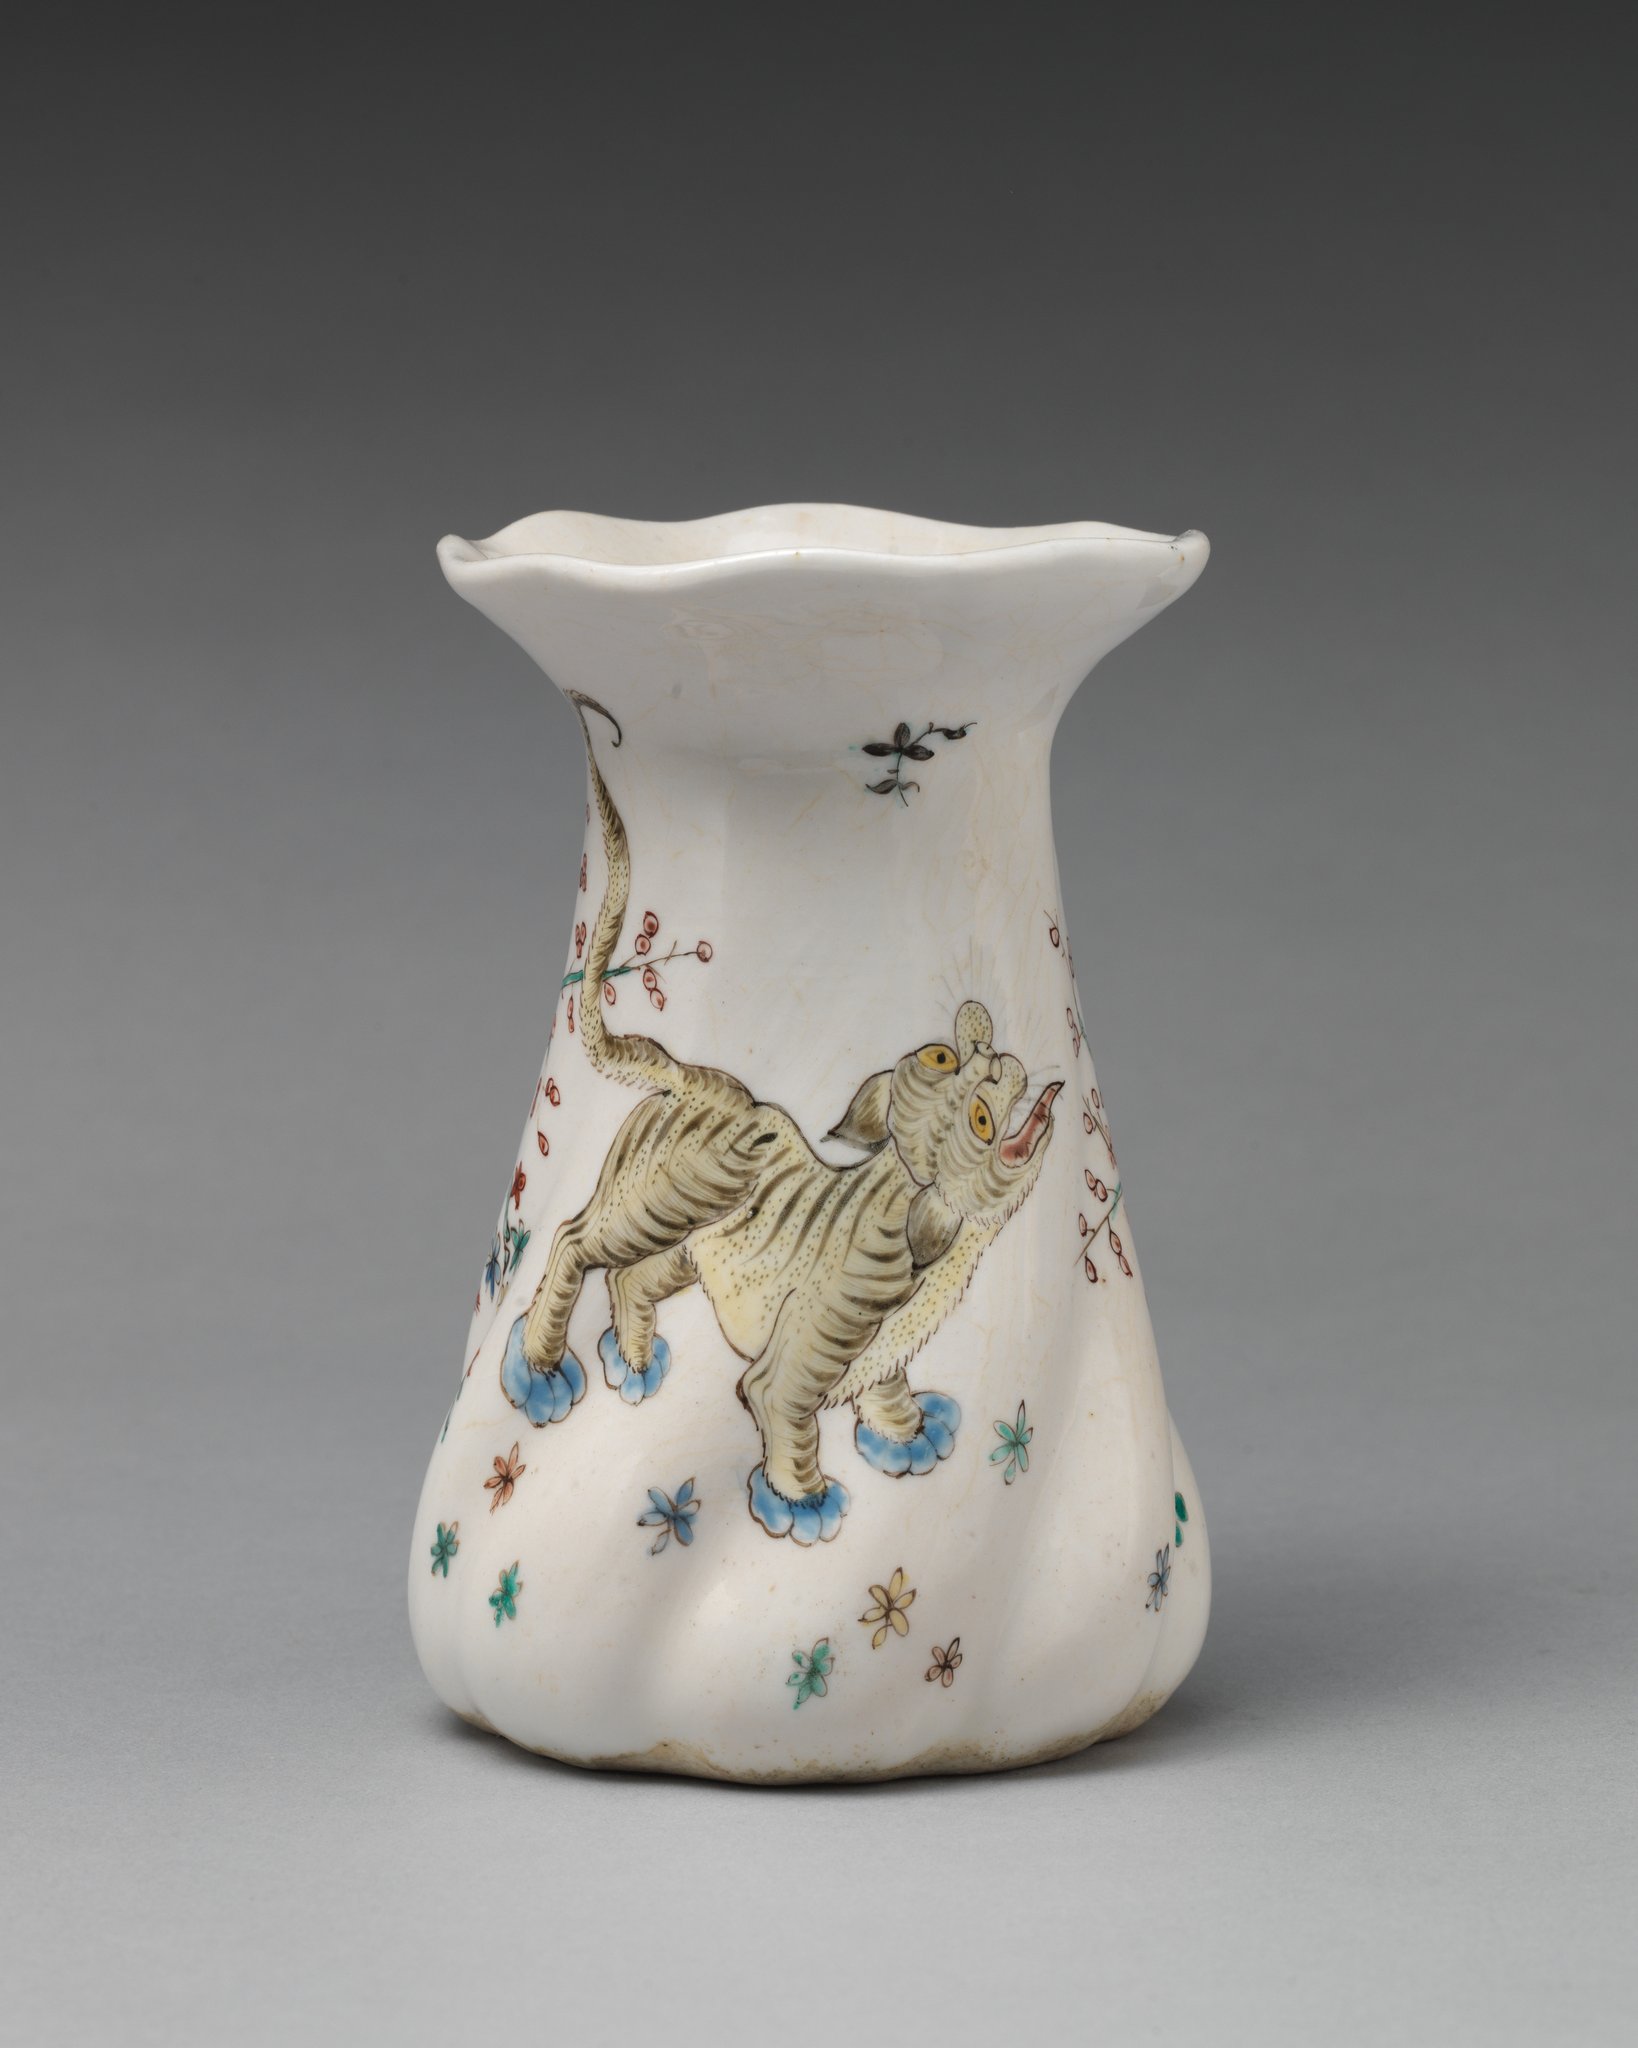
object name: jar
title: Jar (bulb pot)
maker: chelsea porcelain manufactory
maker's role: factory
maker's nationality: british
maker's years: 1744-1784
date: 1748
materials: soft paste porcelain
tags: tigers,flowers